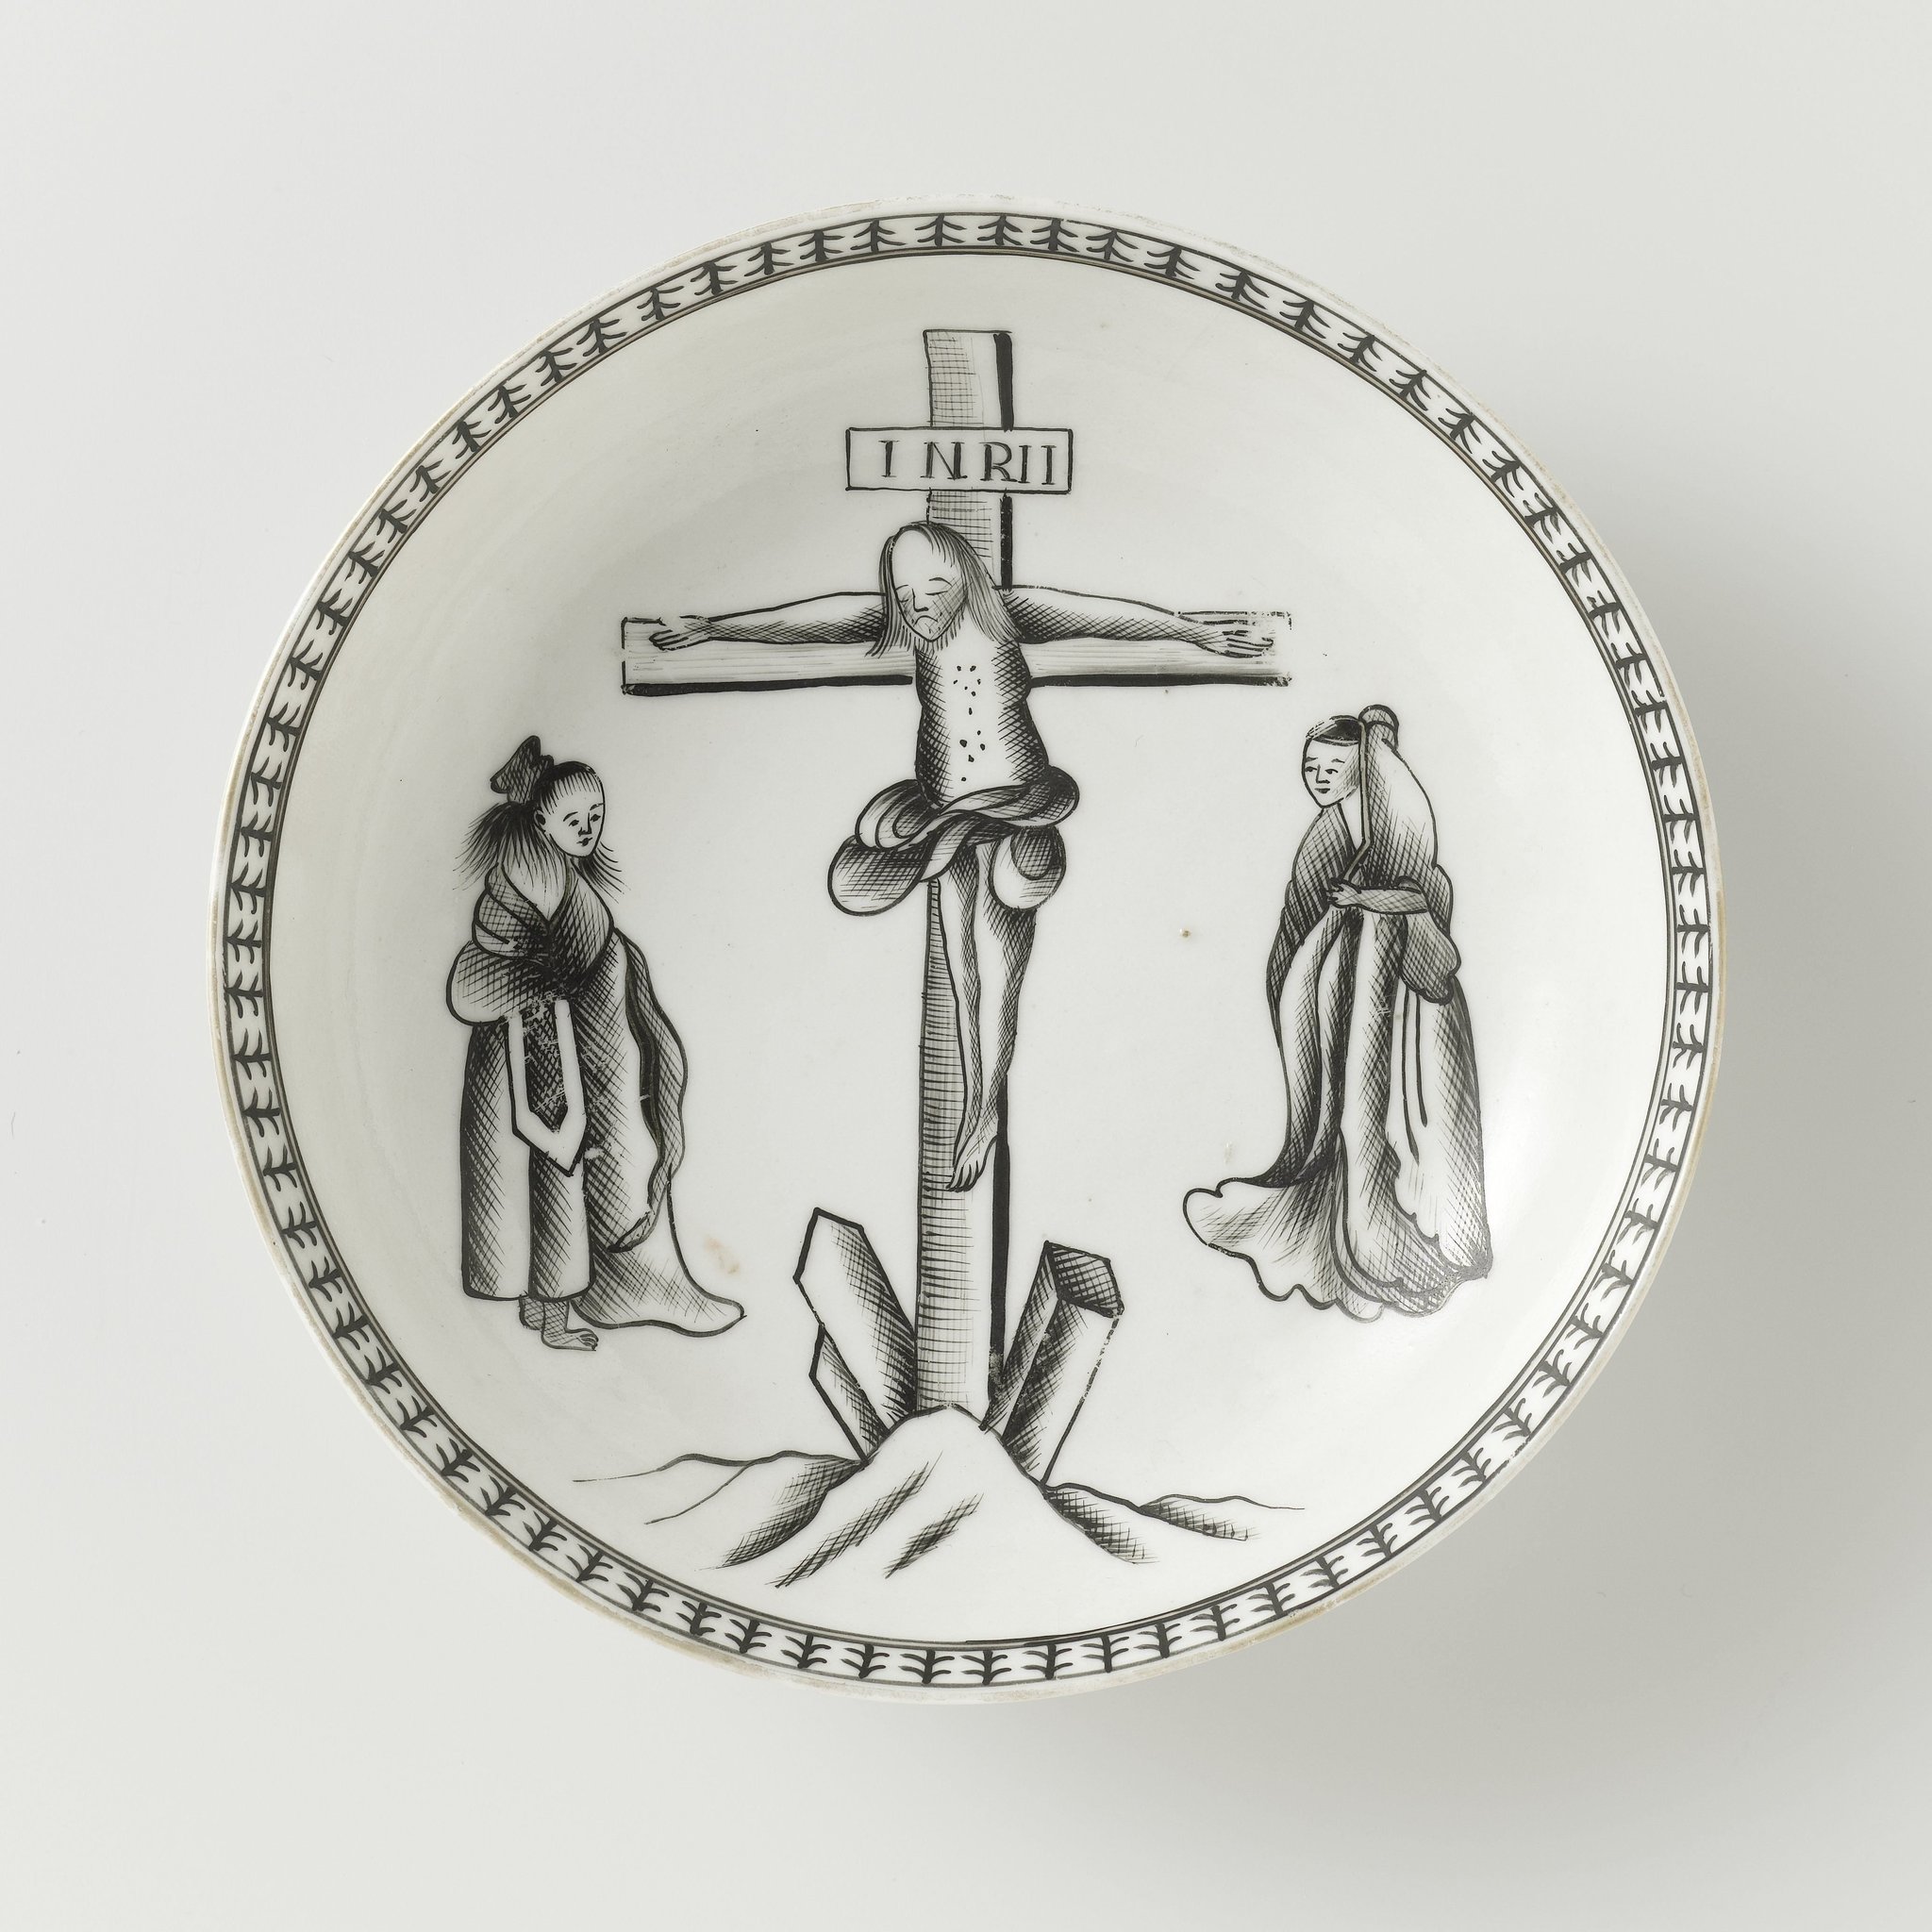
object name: platter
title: Saucer with a crucifixion scene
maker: Anonymous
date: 1780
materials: glaze, gold, paint, porcelain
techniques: firing, gilding, turning, vitrification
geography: china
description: Schotel van porselein, beschilderd op het glazuur in zwart en goud. Op het plat van de schotel een voorstelling van de Kruisiging met de twee Maria's; op de rand een band met een decoratief patroon. Onderdeel van een theeservies. Europese voorstelling in encre de Chine.